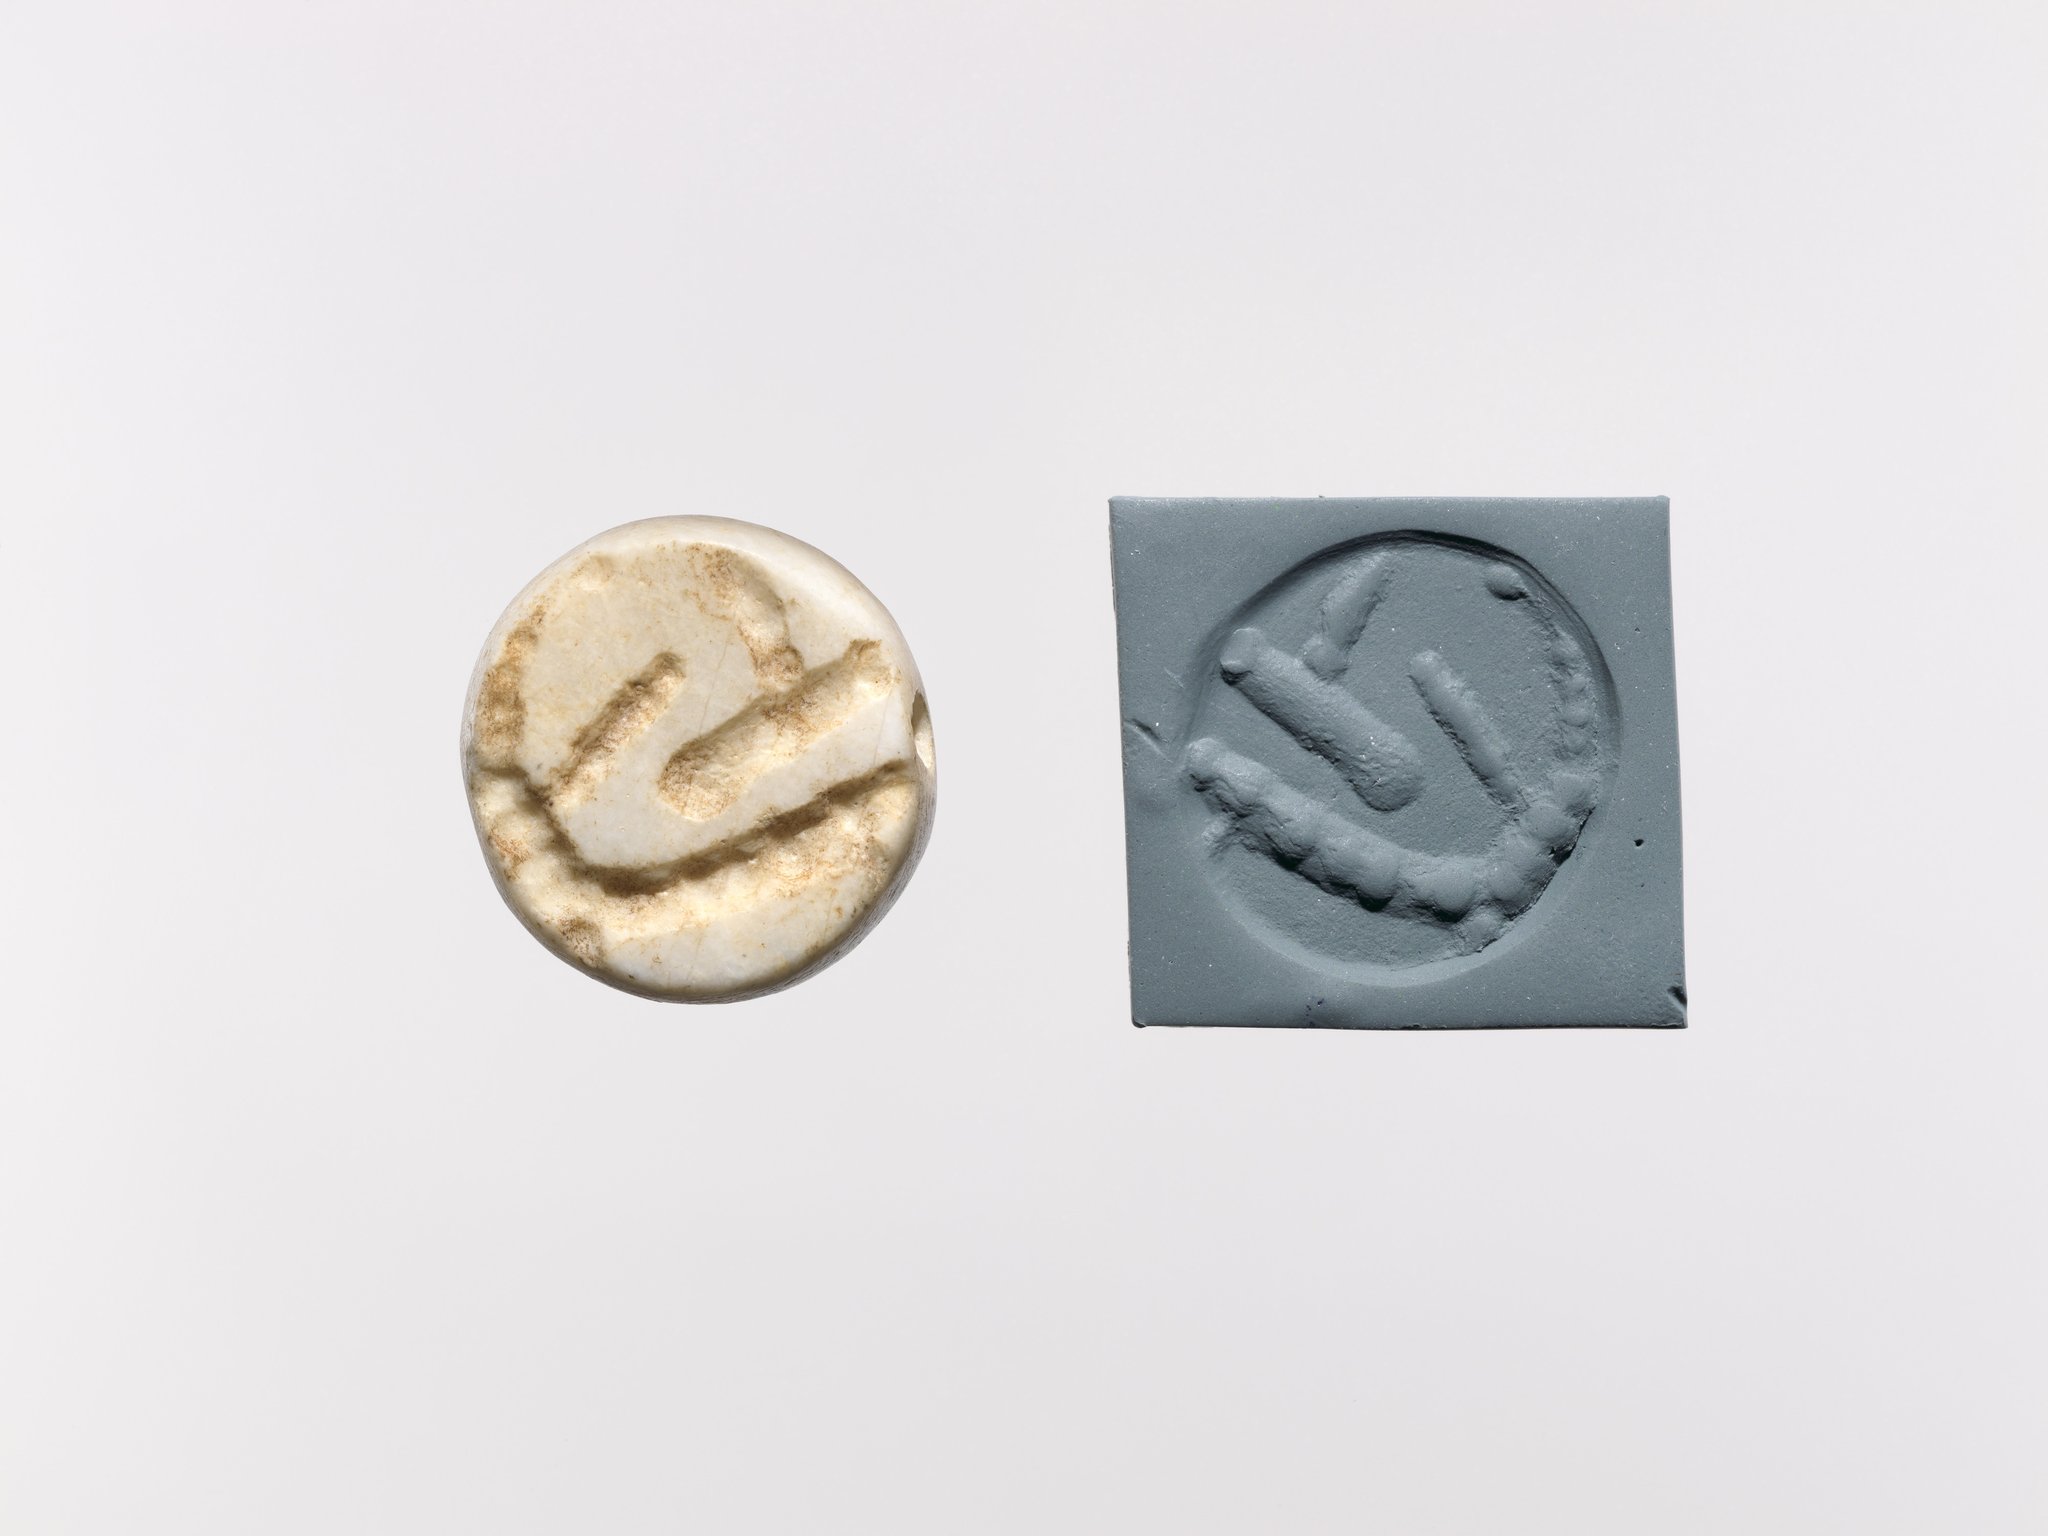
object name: stamp seal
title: Discoid seal with convex back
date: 2900-2700 BCE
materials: stone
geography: mesopotamia